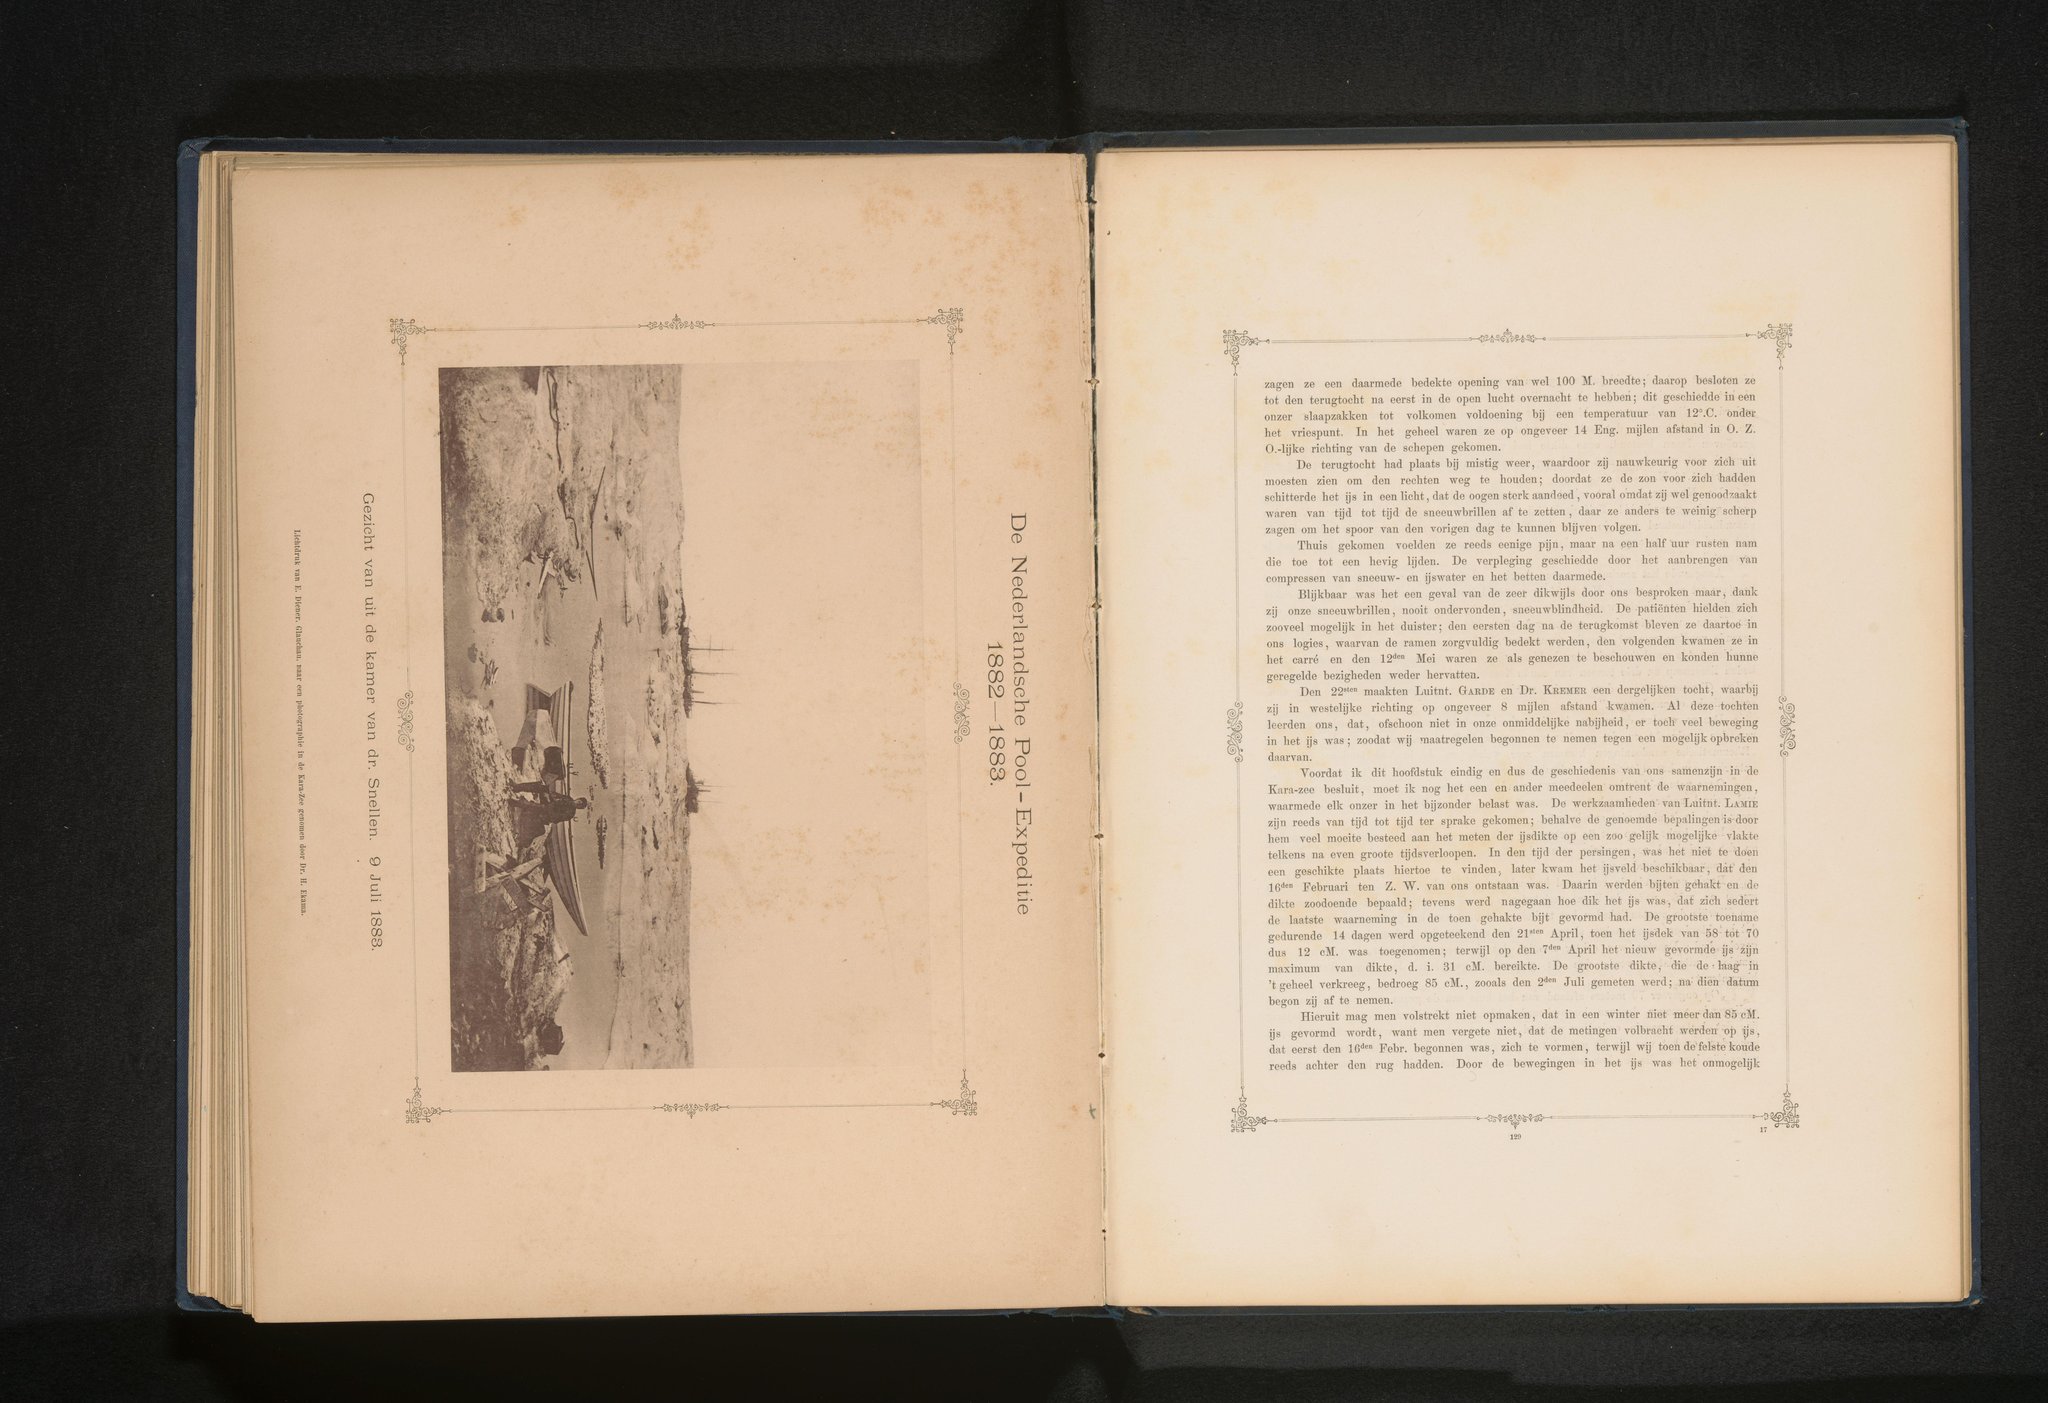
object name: page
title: Gezicht van uit de kamer van dr. Snellen. 9 Juli 1883.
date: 1881-1886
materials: paper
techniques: photograph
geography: glauchau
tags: icefield, ships (in general), landscapes in polar regions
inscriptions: inscription: ‘De Nederlandsche Pool-Expeditie 1882-1883’